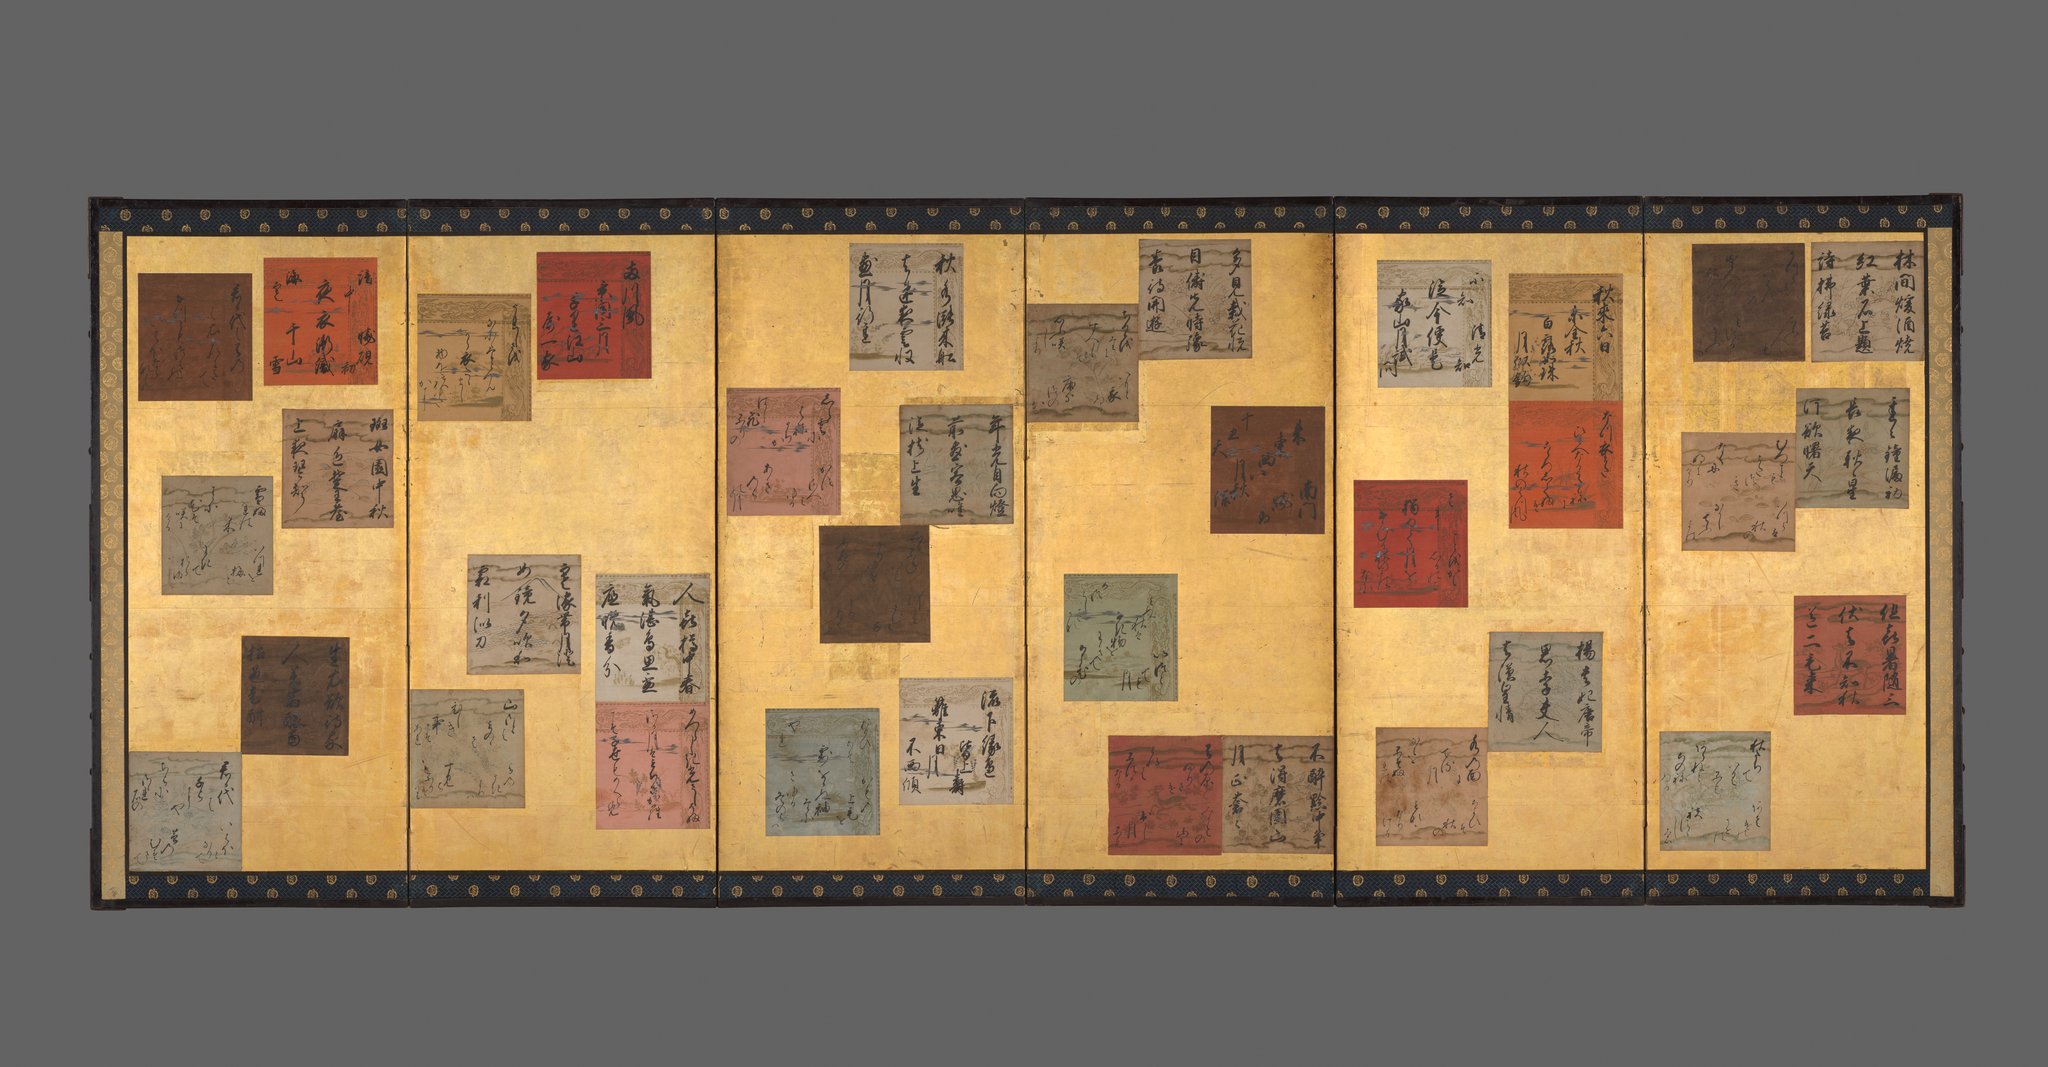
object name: screen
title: Japanese and Chinese Poems of the Four Seasons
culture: japanese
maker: konoe sakihisa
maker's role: artist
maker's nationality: japanese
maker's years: 1536-1612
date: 1567-1633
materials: gold leaf, ink, panel, paper, pigment